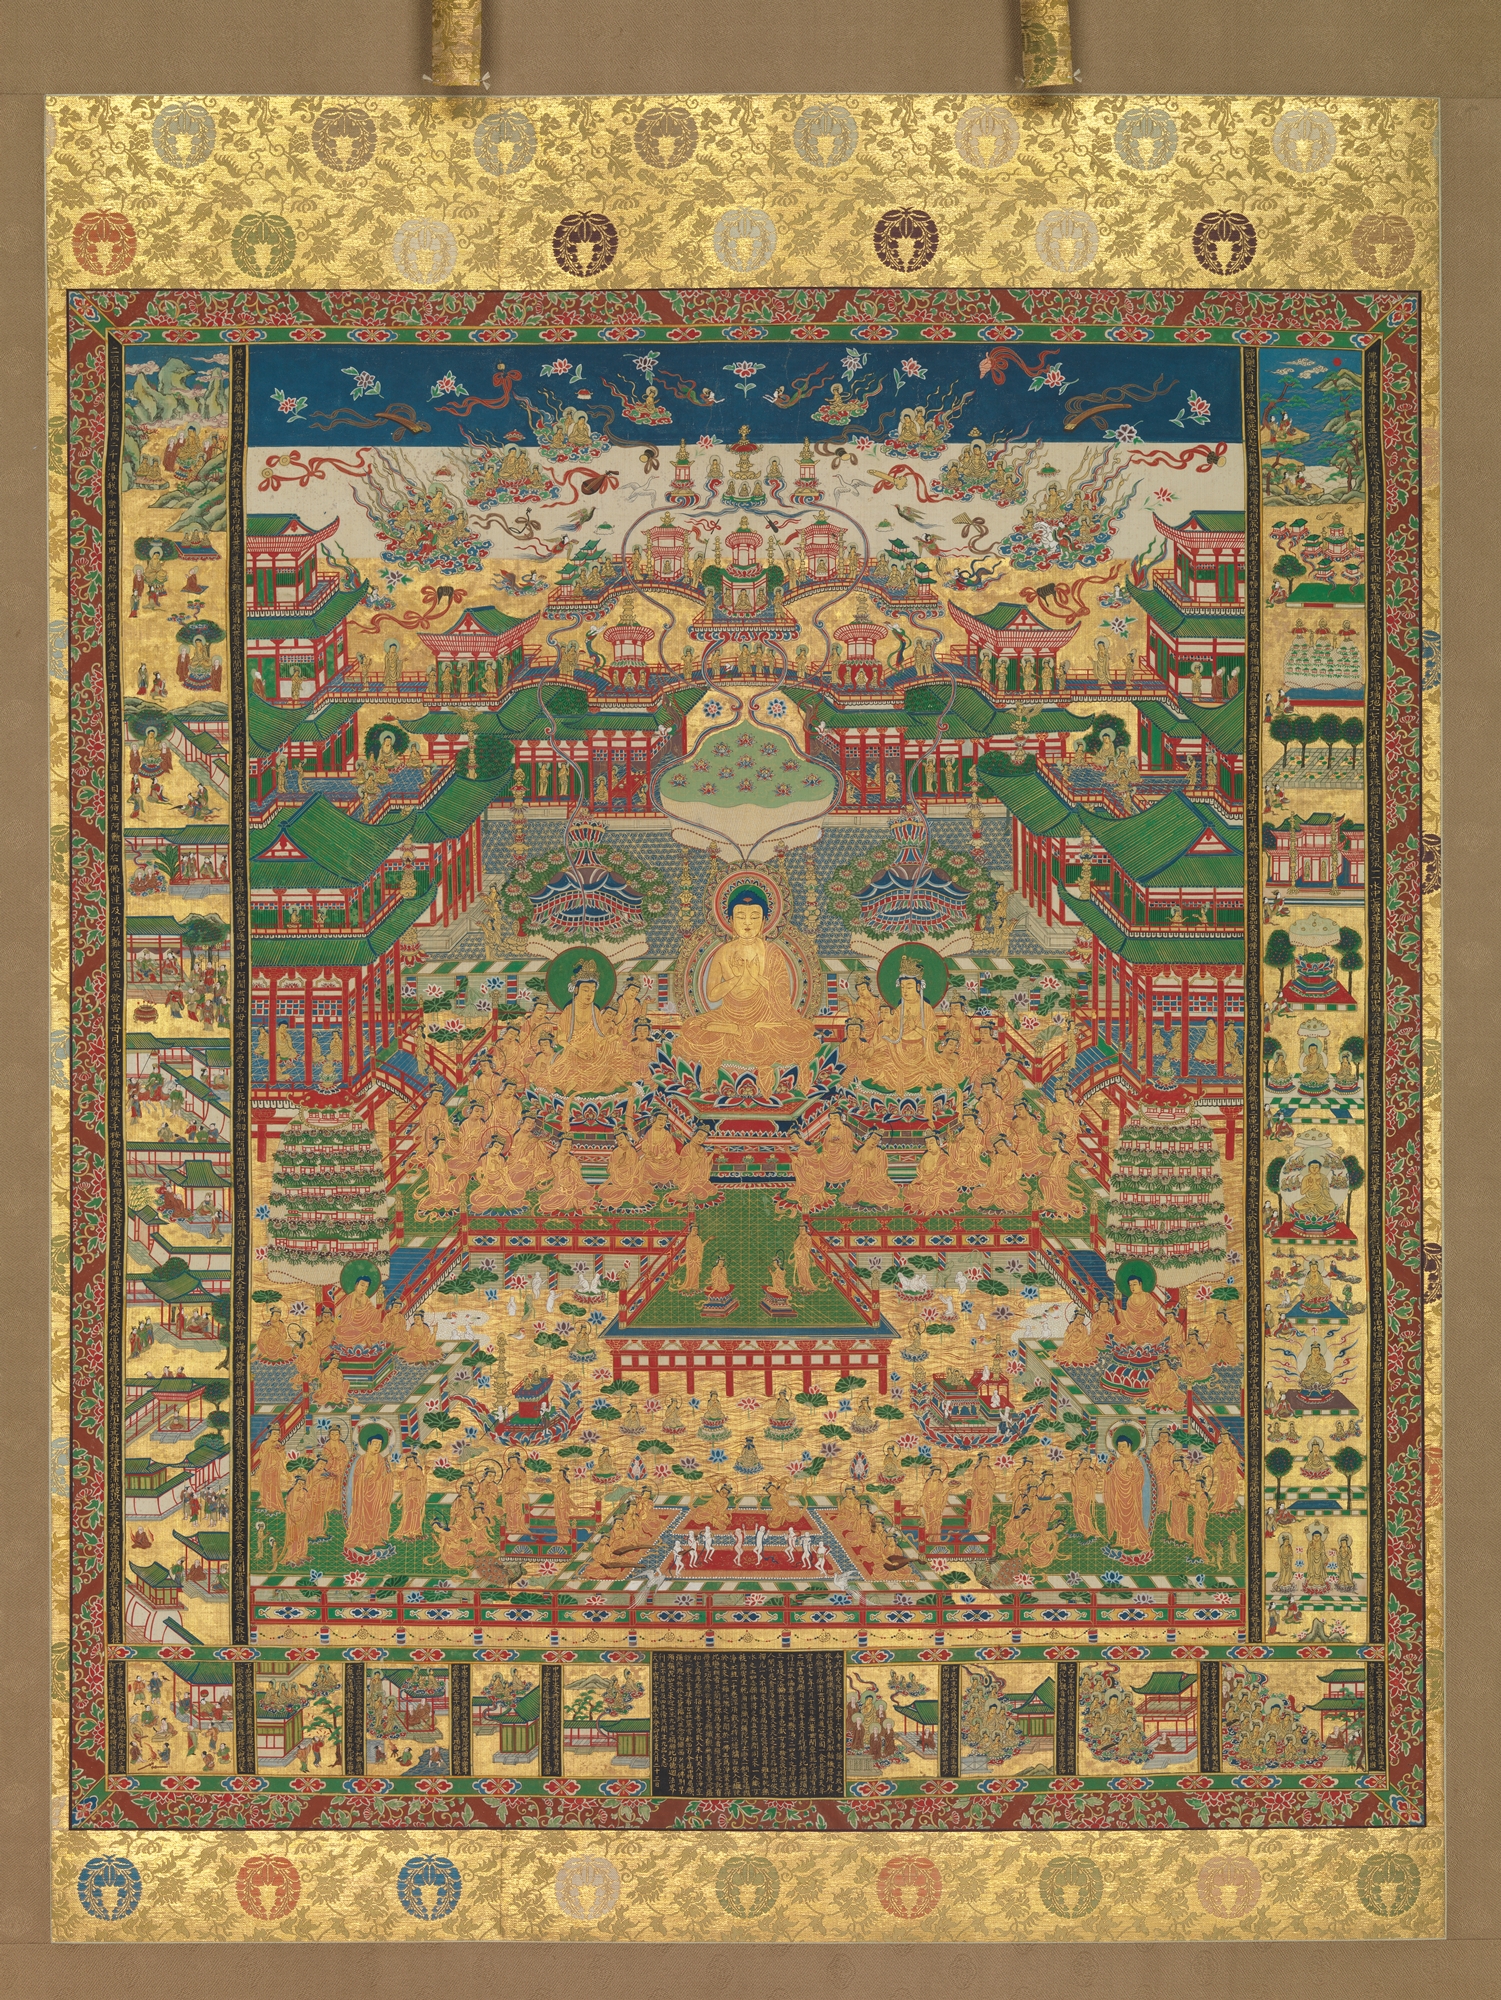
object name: hanging scroll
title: Taima Mandala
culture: japanese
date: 1750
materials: gold, ink, silk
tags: palaces,buddhism,buddha